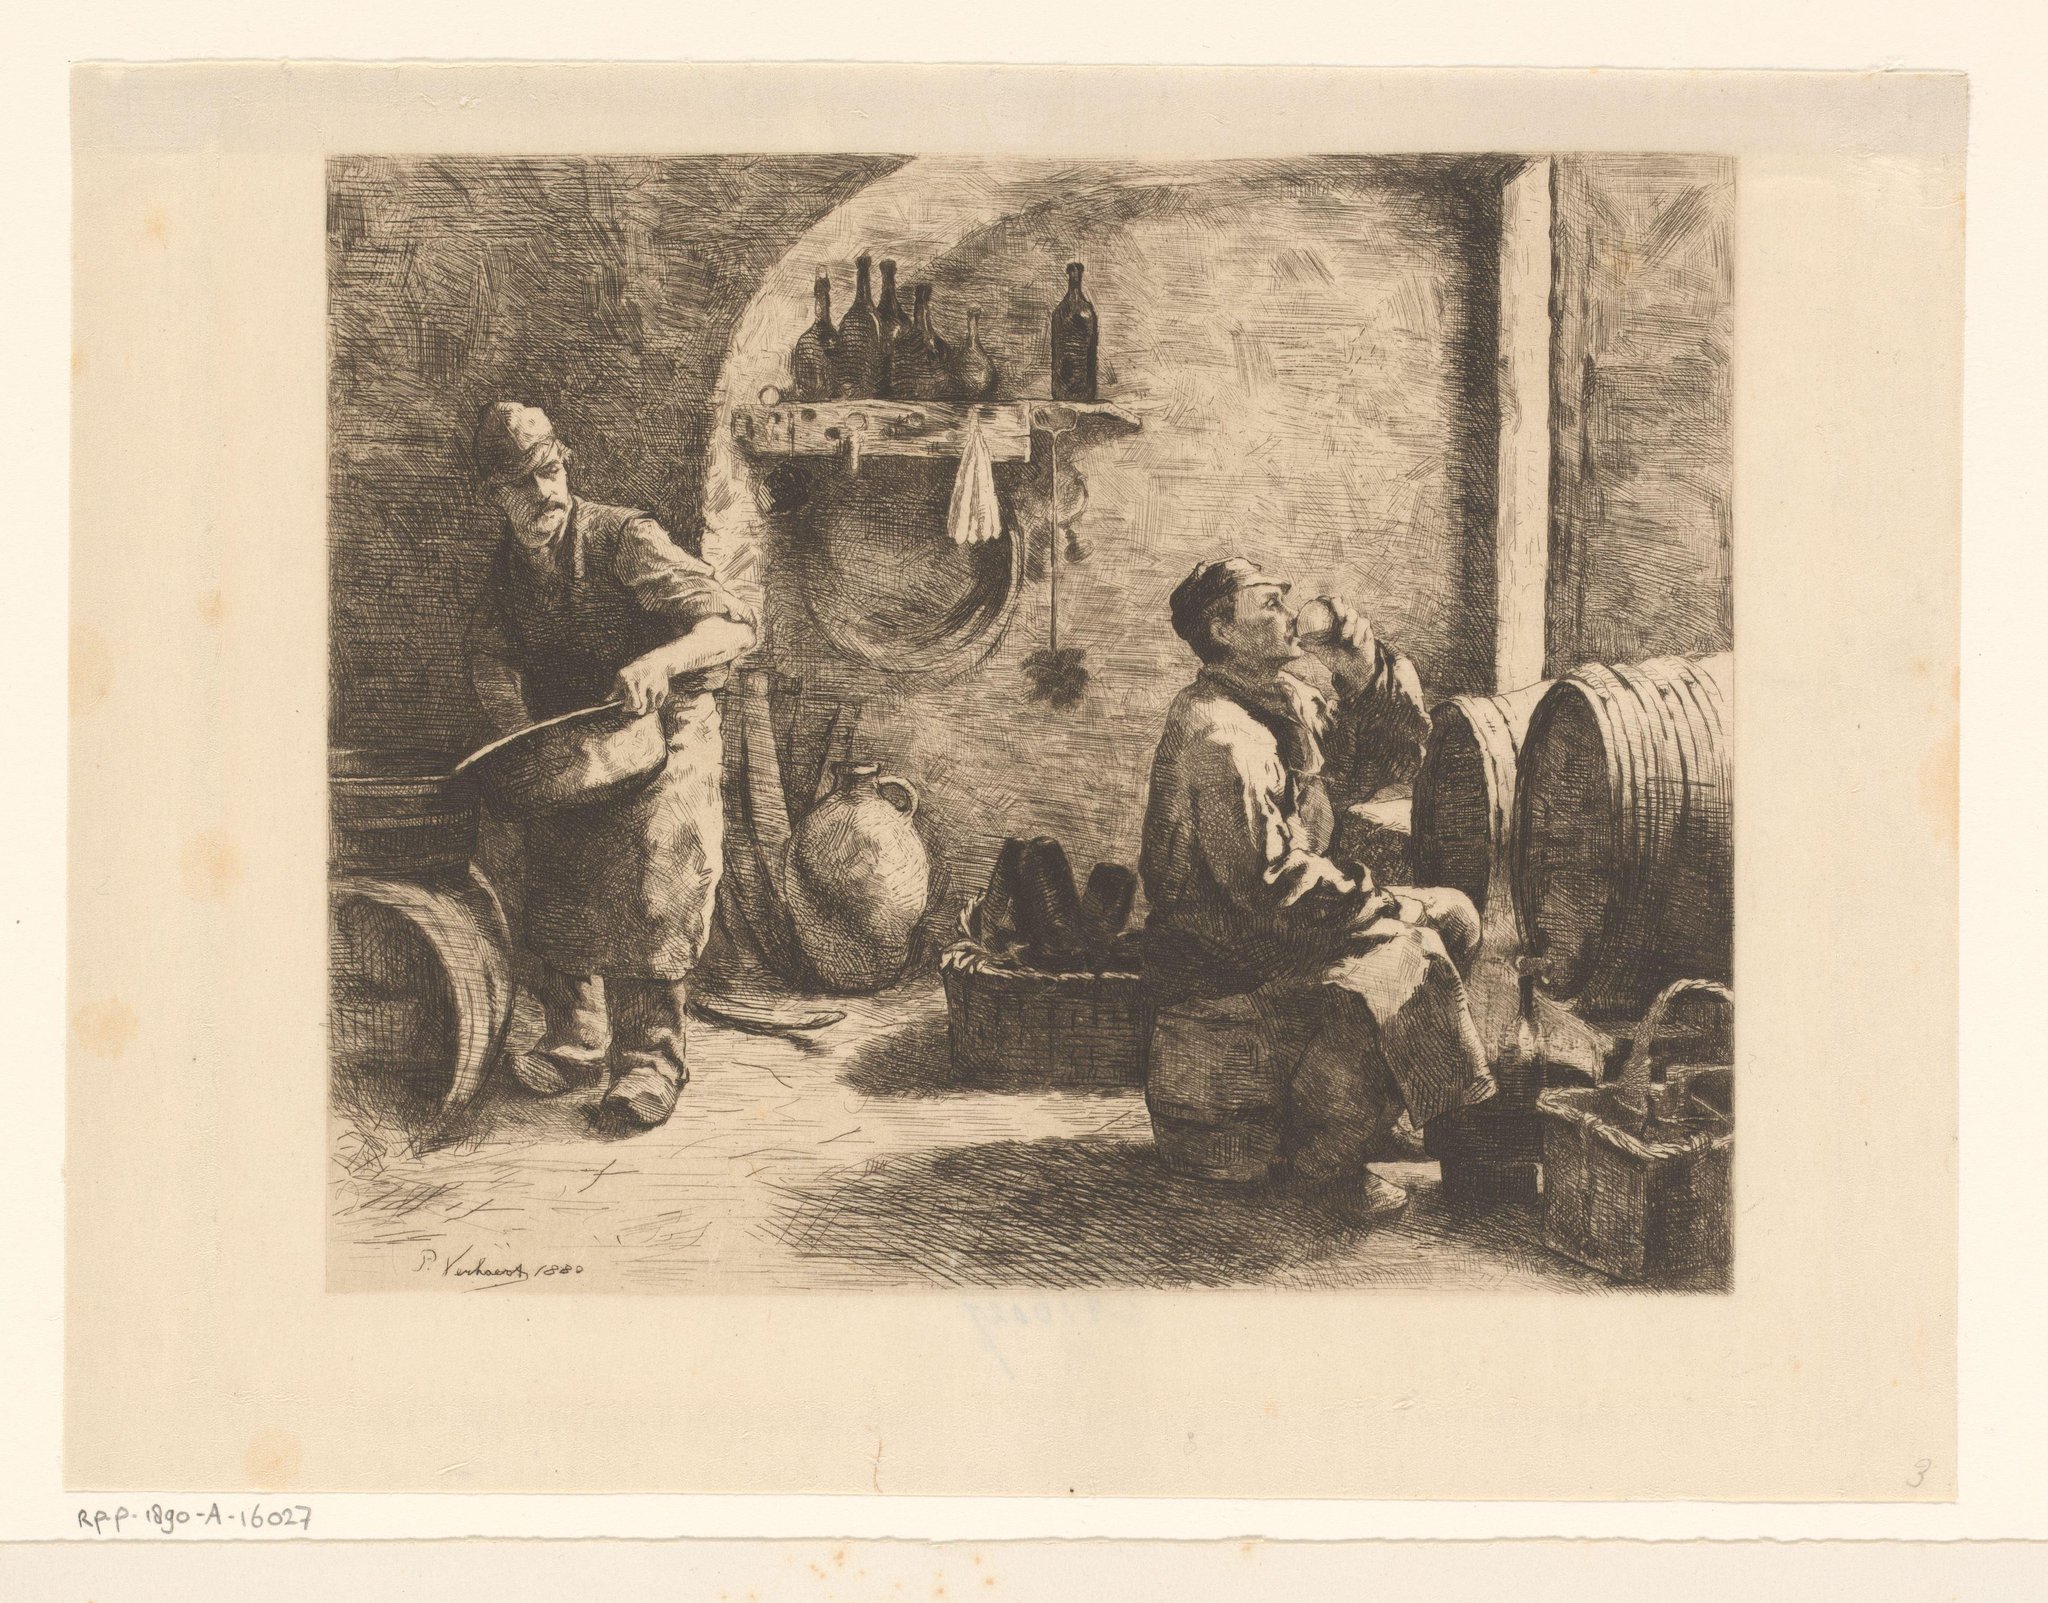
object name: print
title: Twee bottelaars in hun werkplaats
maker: piet verhaert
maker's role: print maker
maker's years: 1852-1908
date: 1880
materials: paper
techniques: etching, retroussage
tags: container of glass: bottle, jar, vase, workshop-interior, basement, cellar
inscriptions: collector's mark: Lugt 2228, mark: ‘Antwerpsche Etsers 1880’